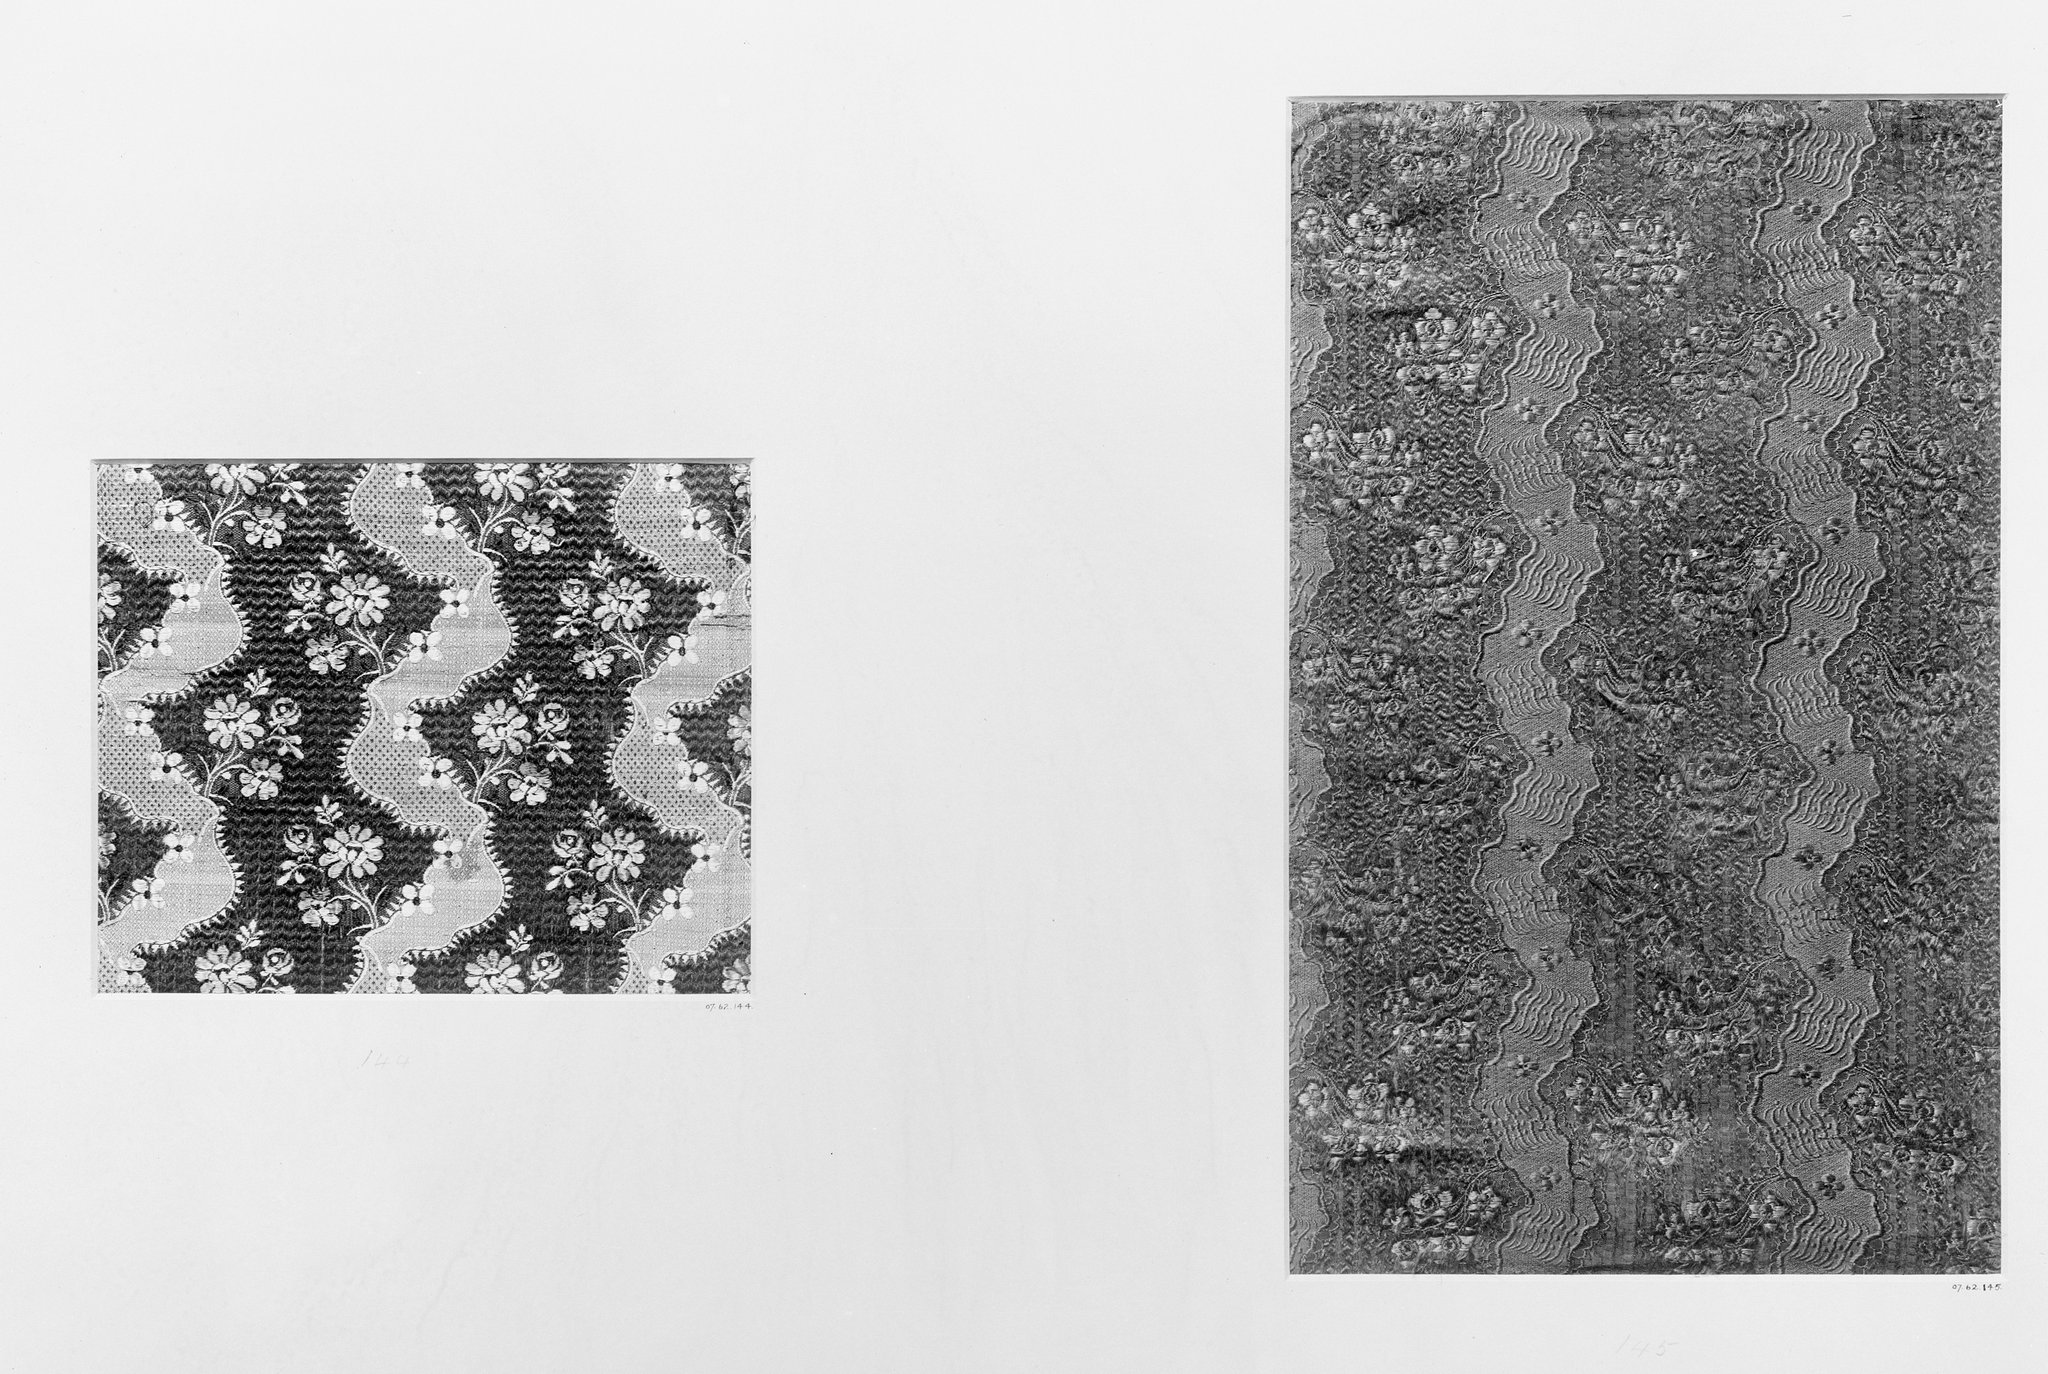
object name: piece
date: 1774-1793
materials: silk